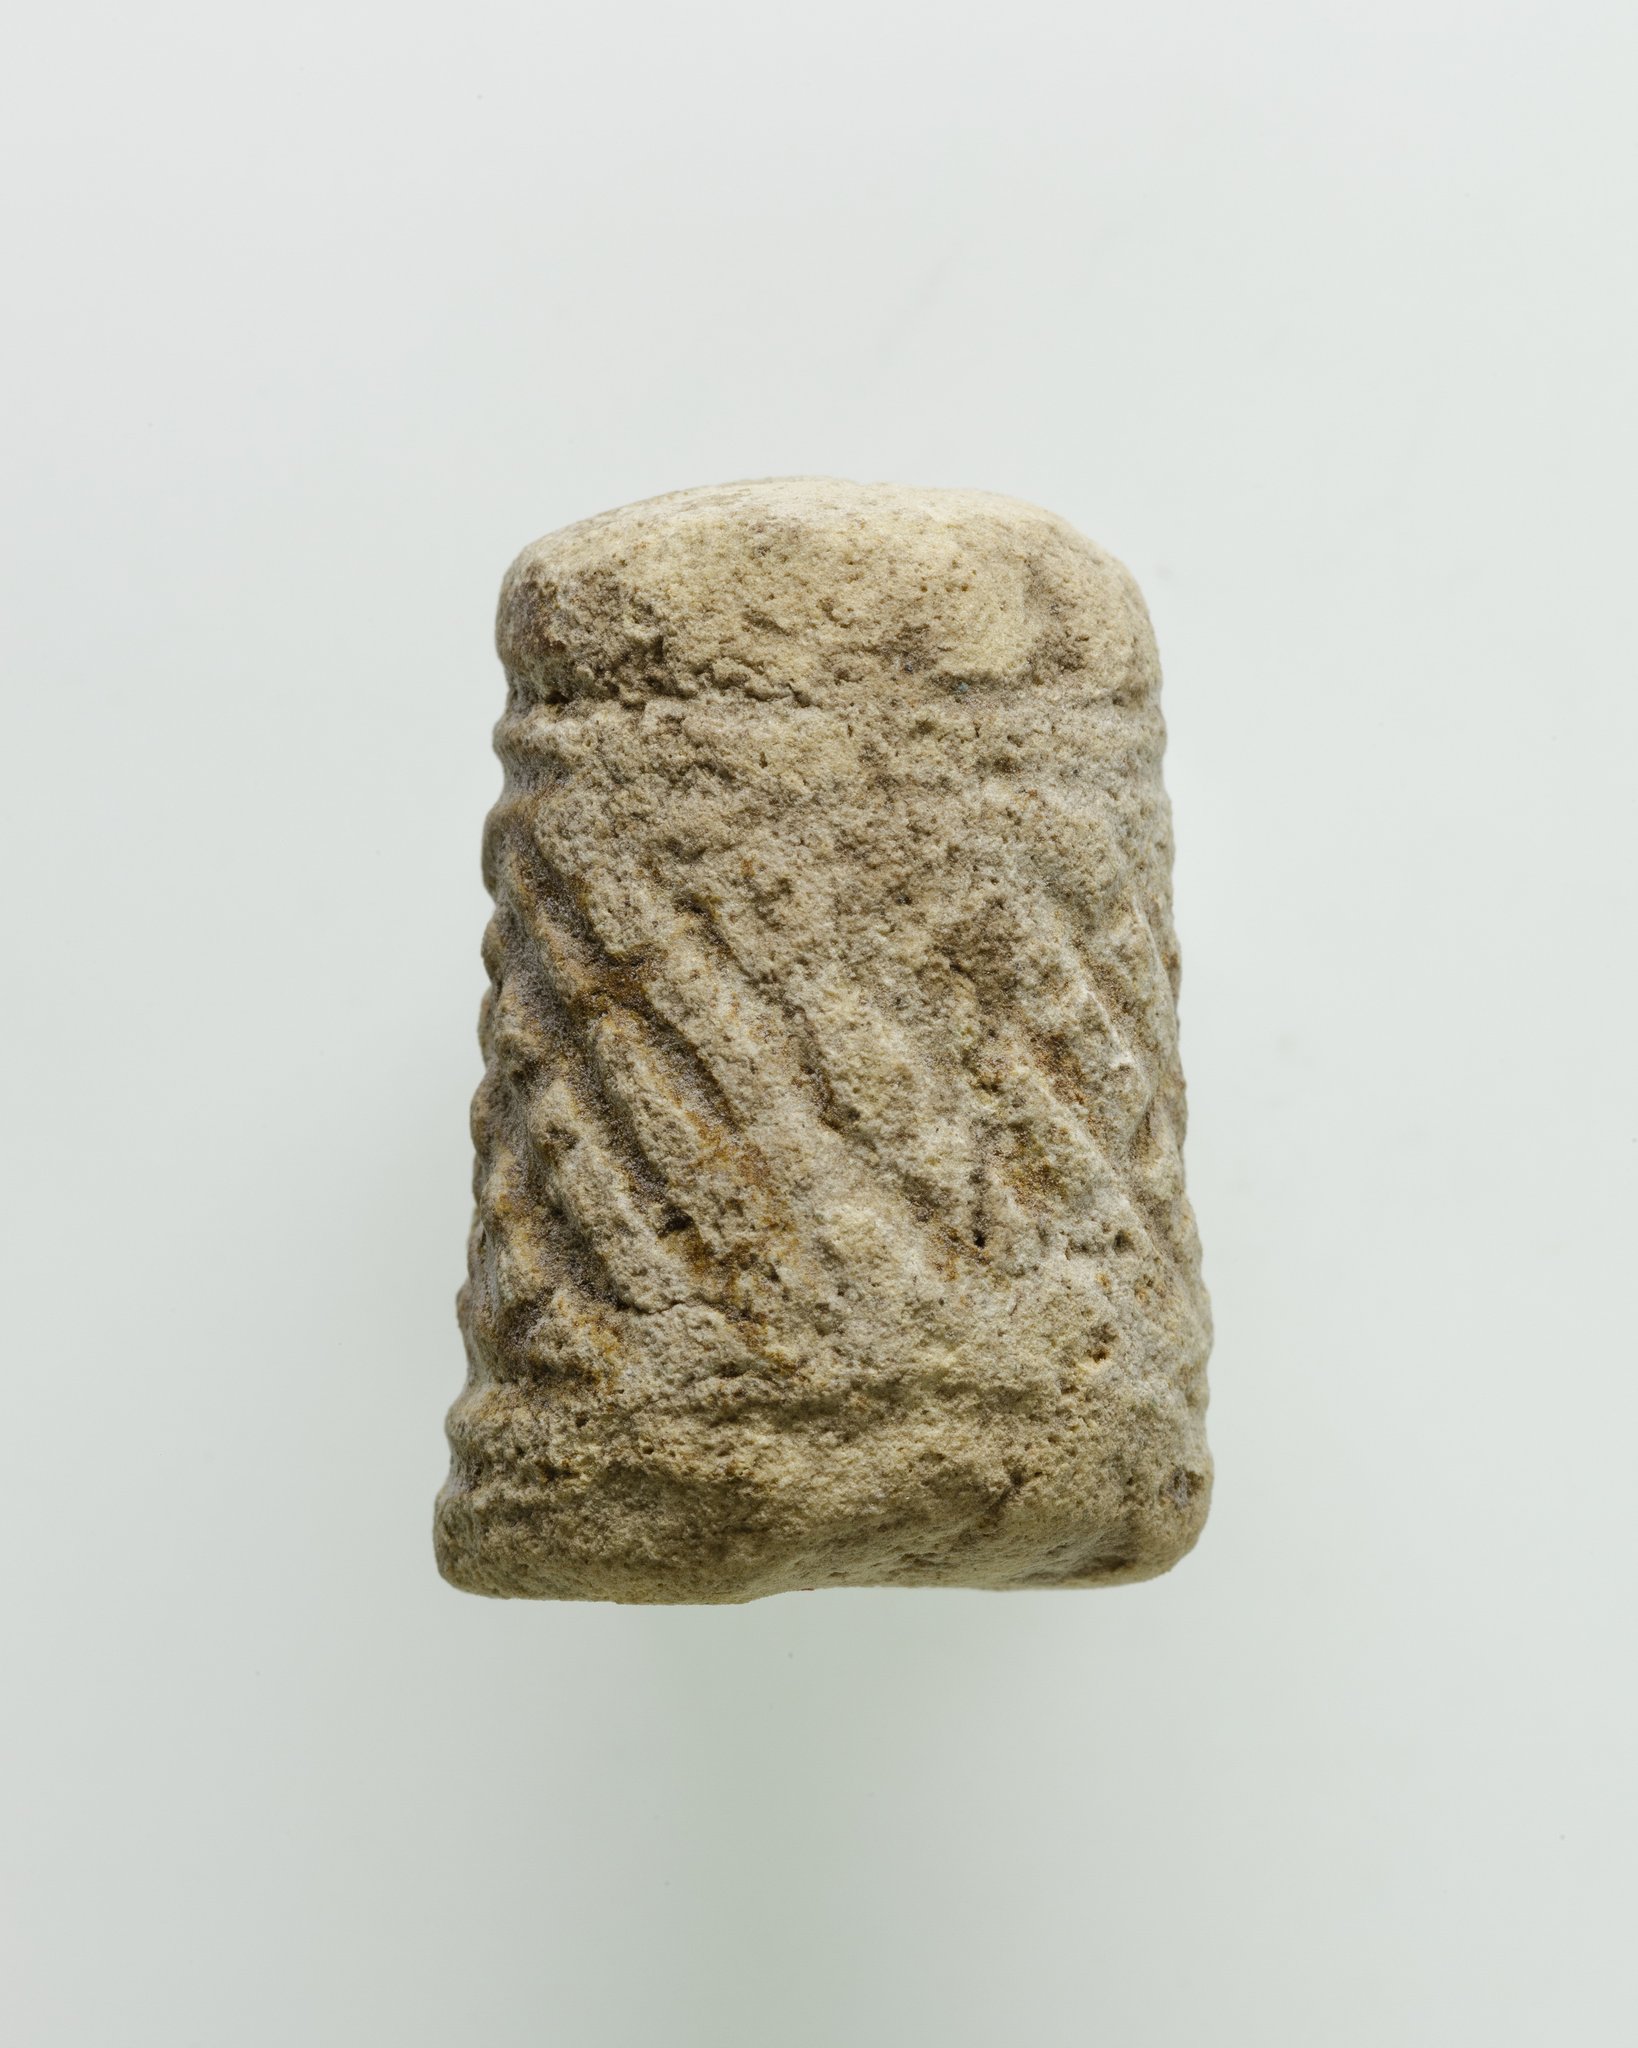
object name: stamp, cylinder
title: Cylinder seal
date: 1295-1070 BCE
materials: limestone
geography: egypt